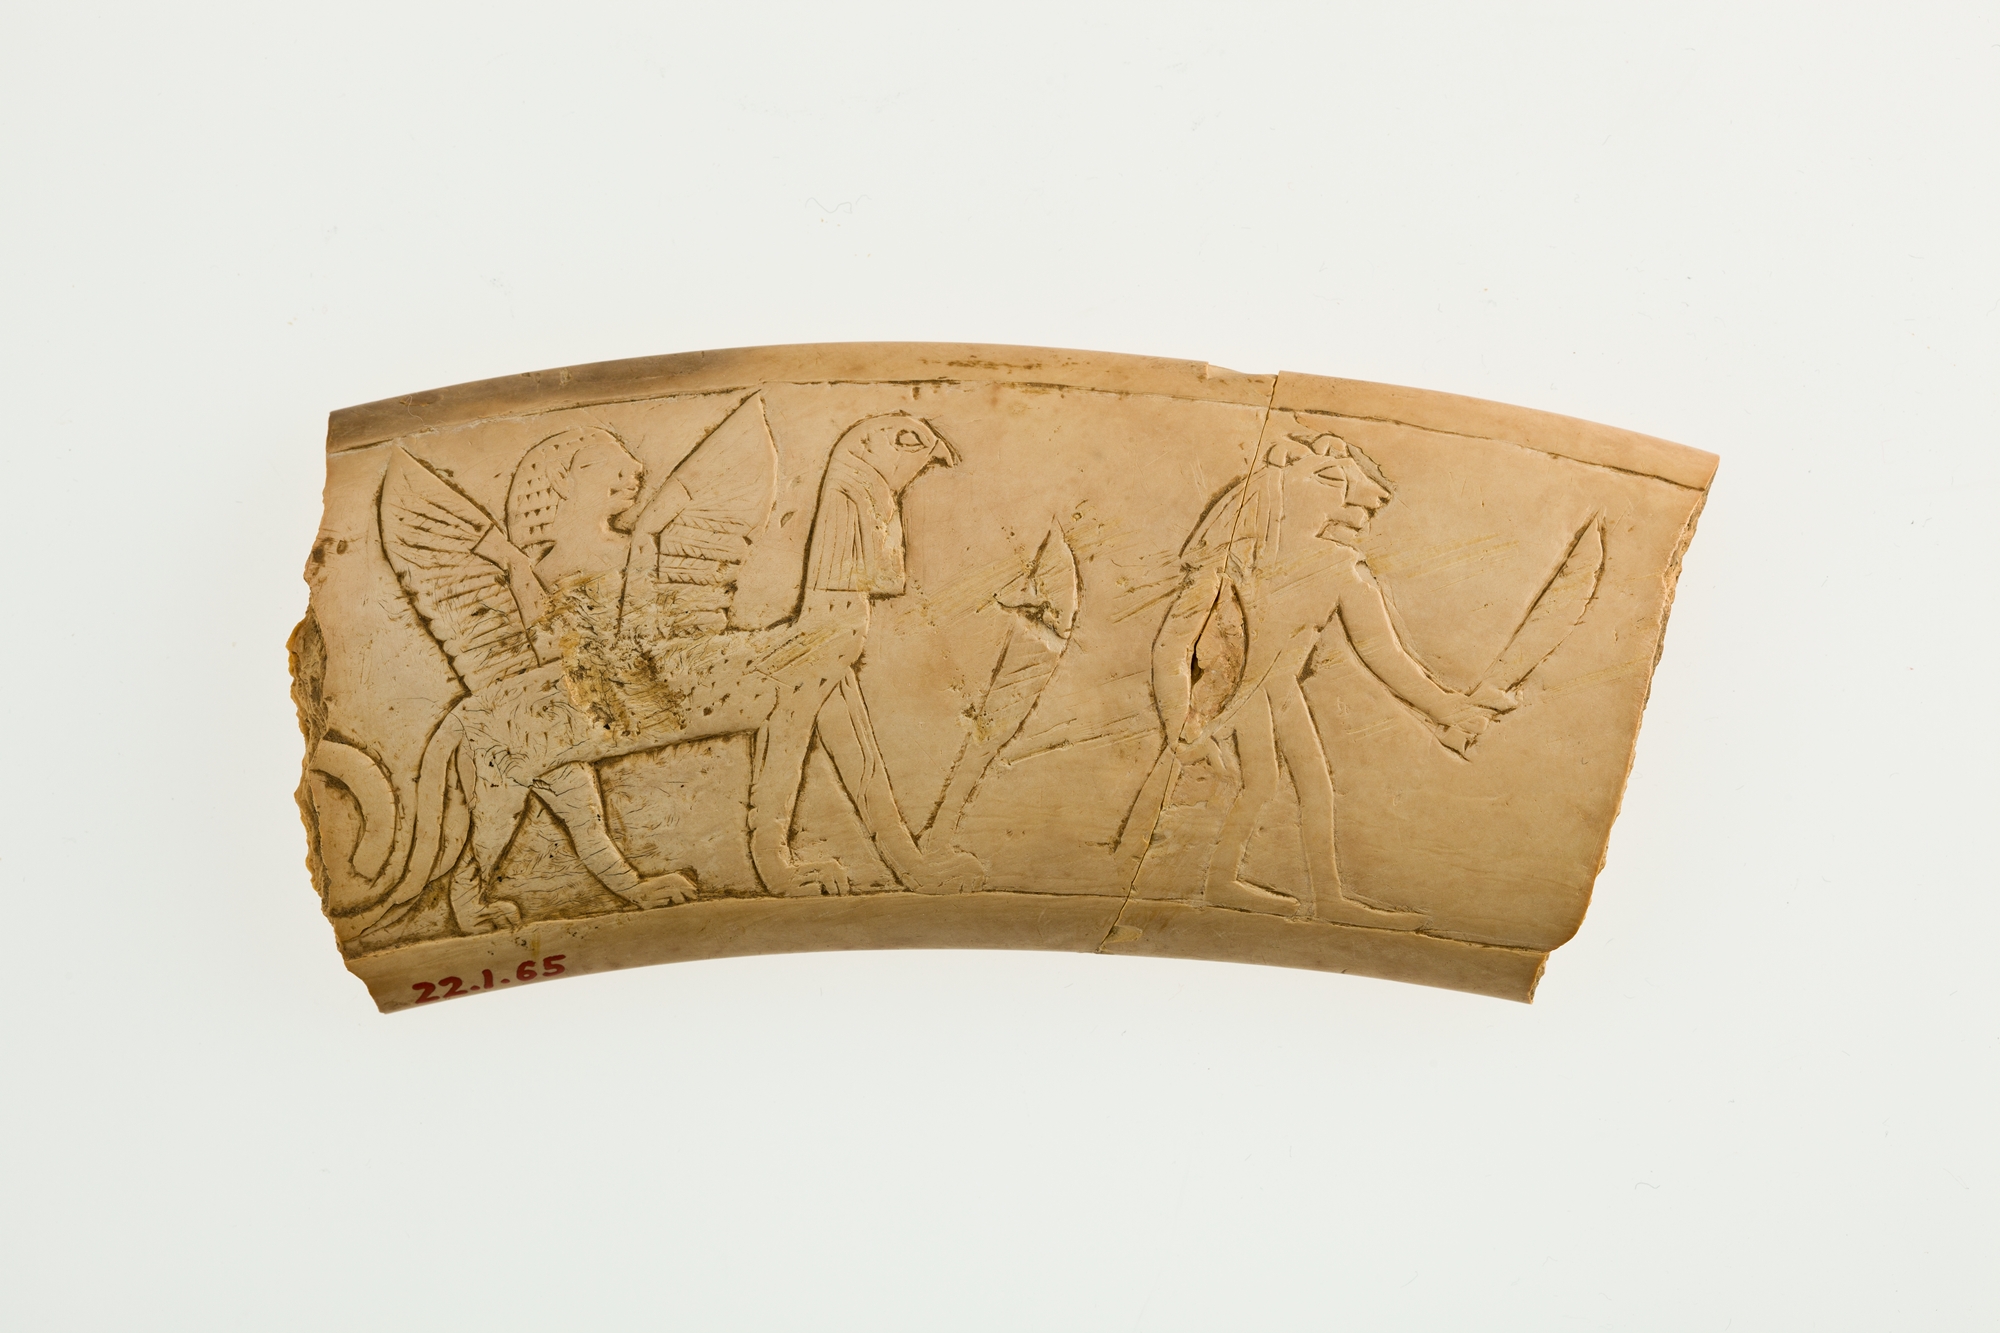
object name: magic wand fragment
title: Magic wand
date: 1750-1640 BCE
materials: ivory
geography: egypt